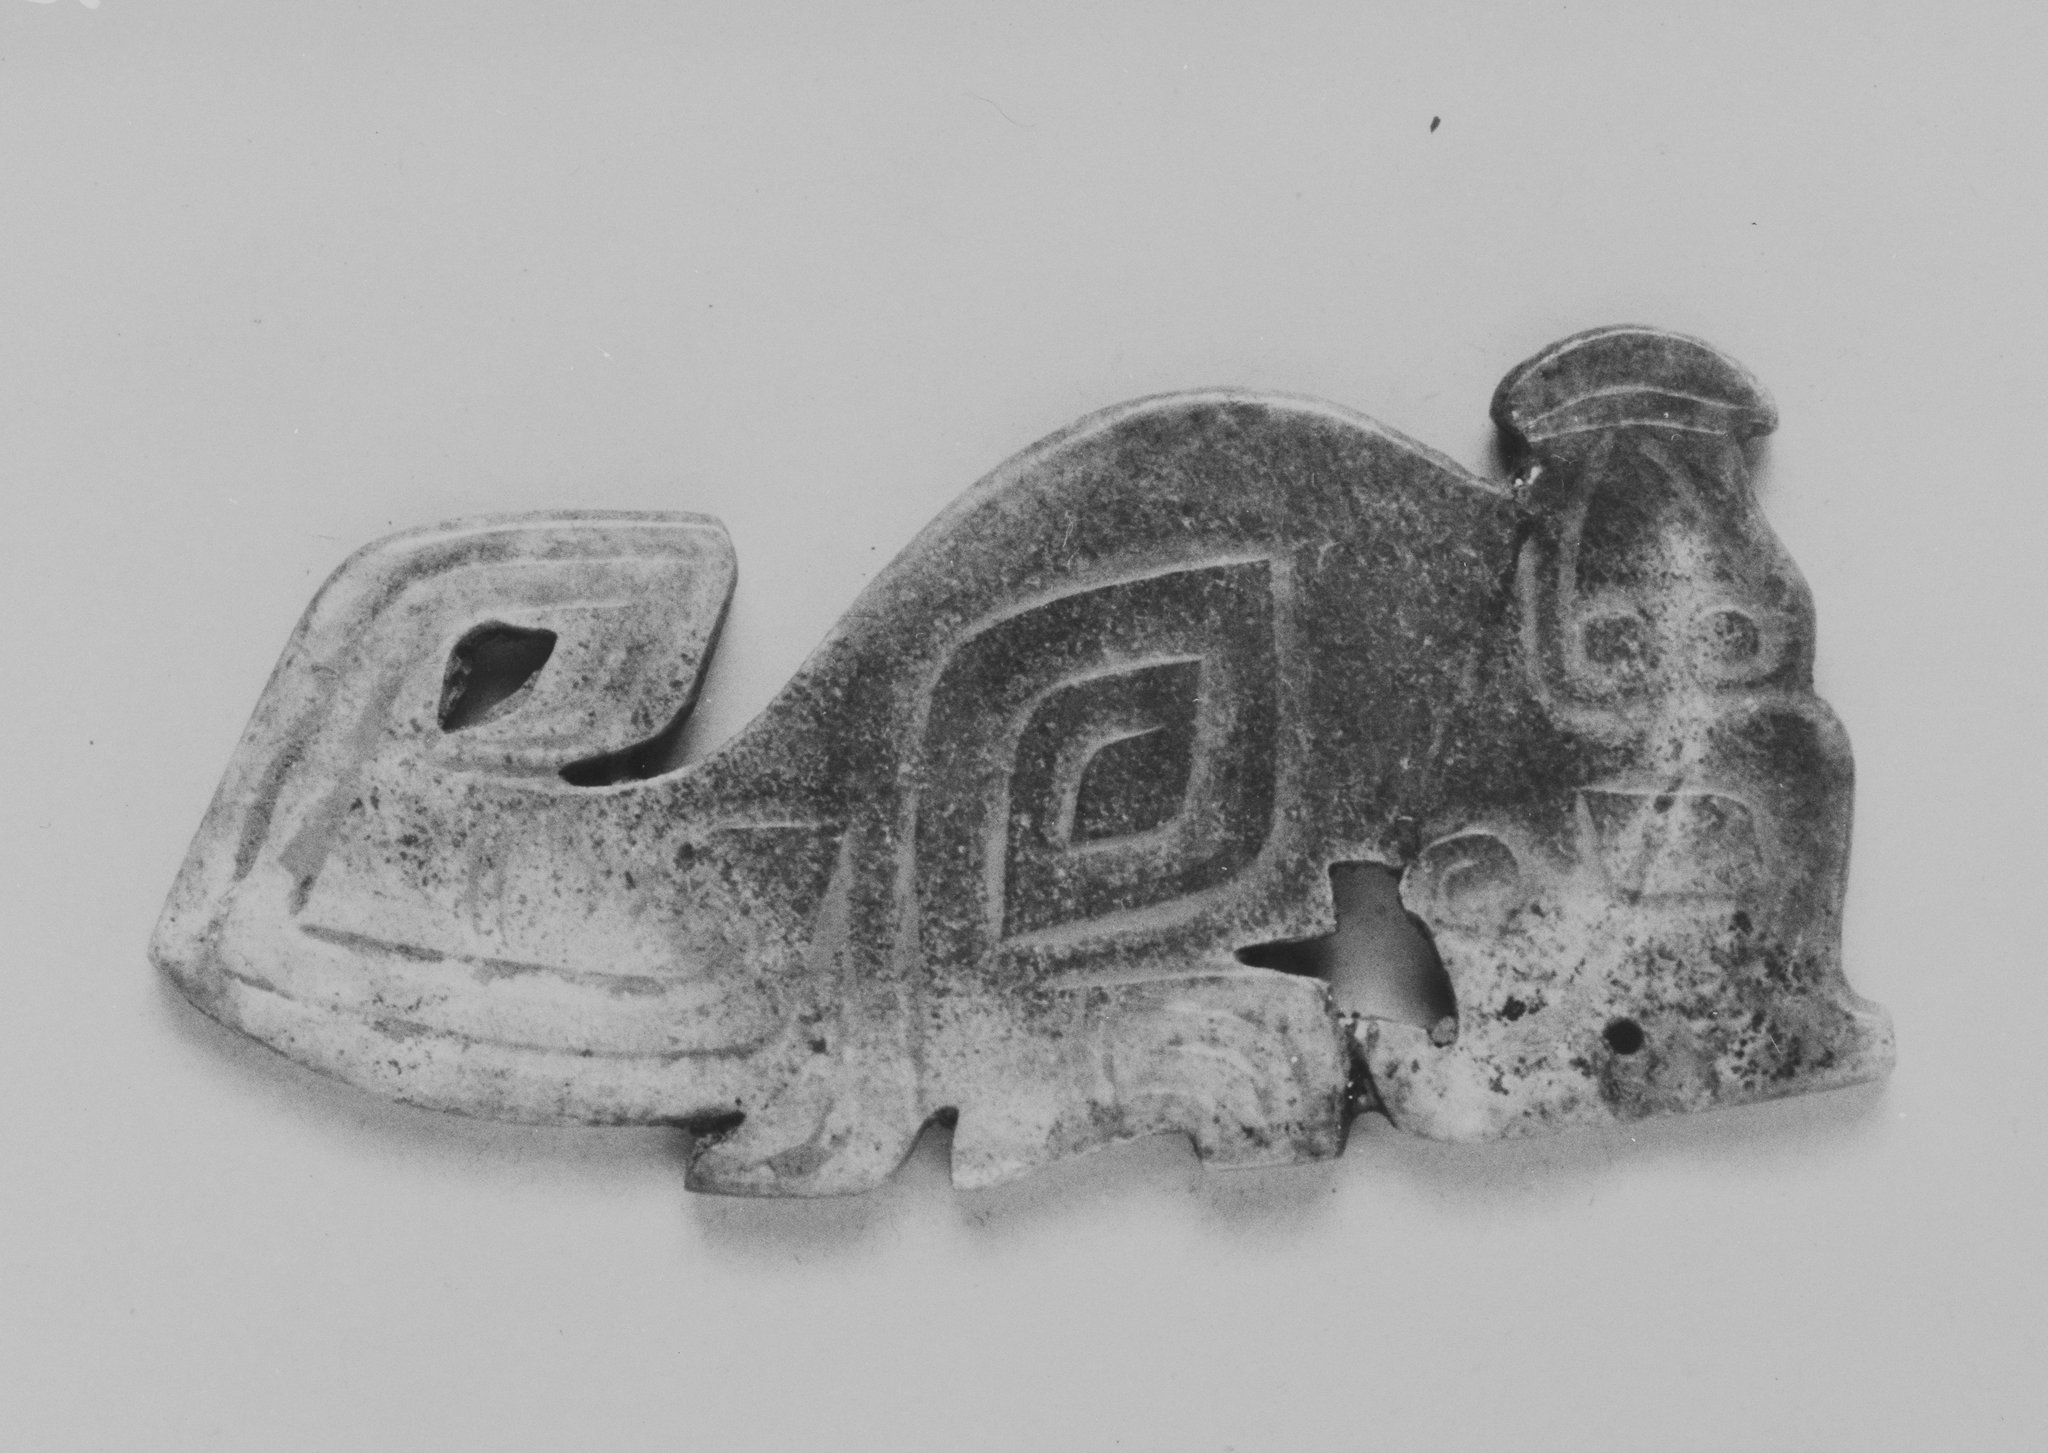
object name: pendant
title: Pendant in the shape of a dragon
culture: chinese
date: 1100-901 BCE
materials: jade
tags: dragons